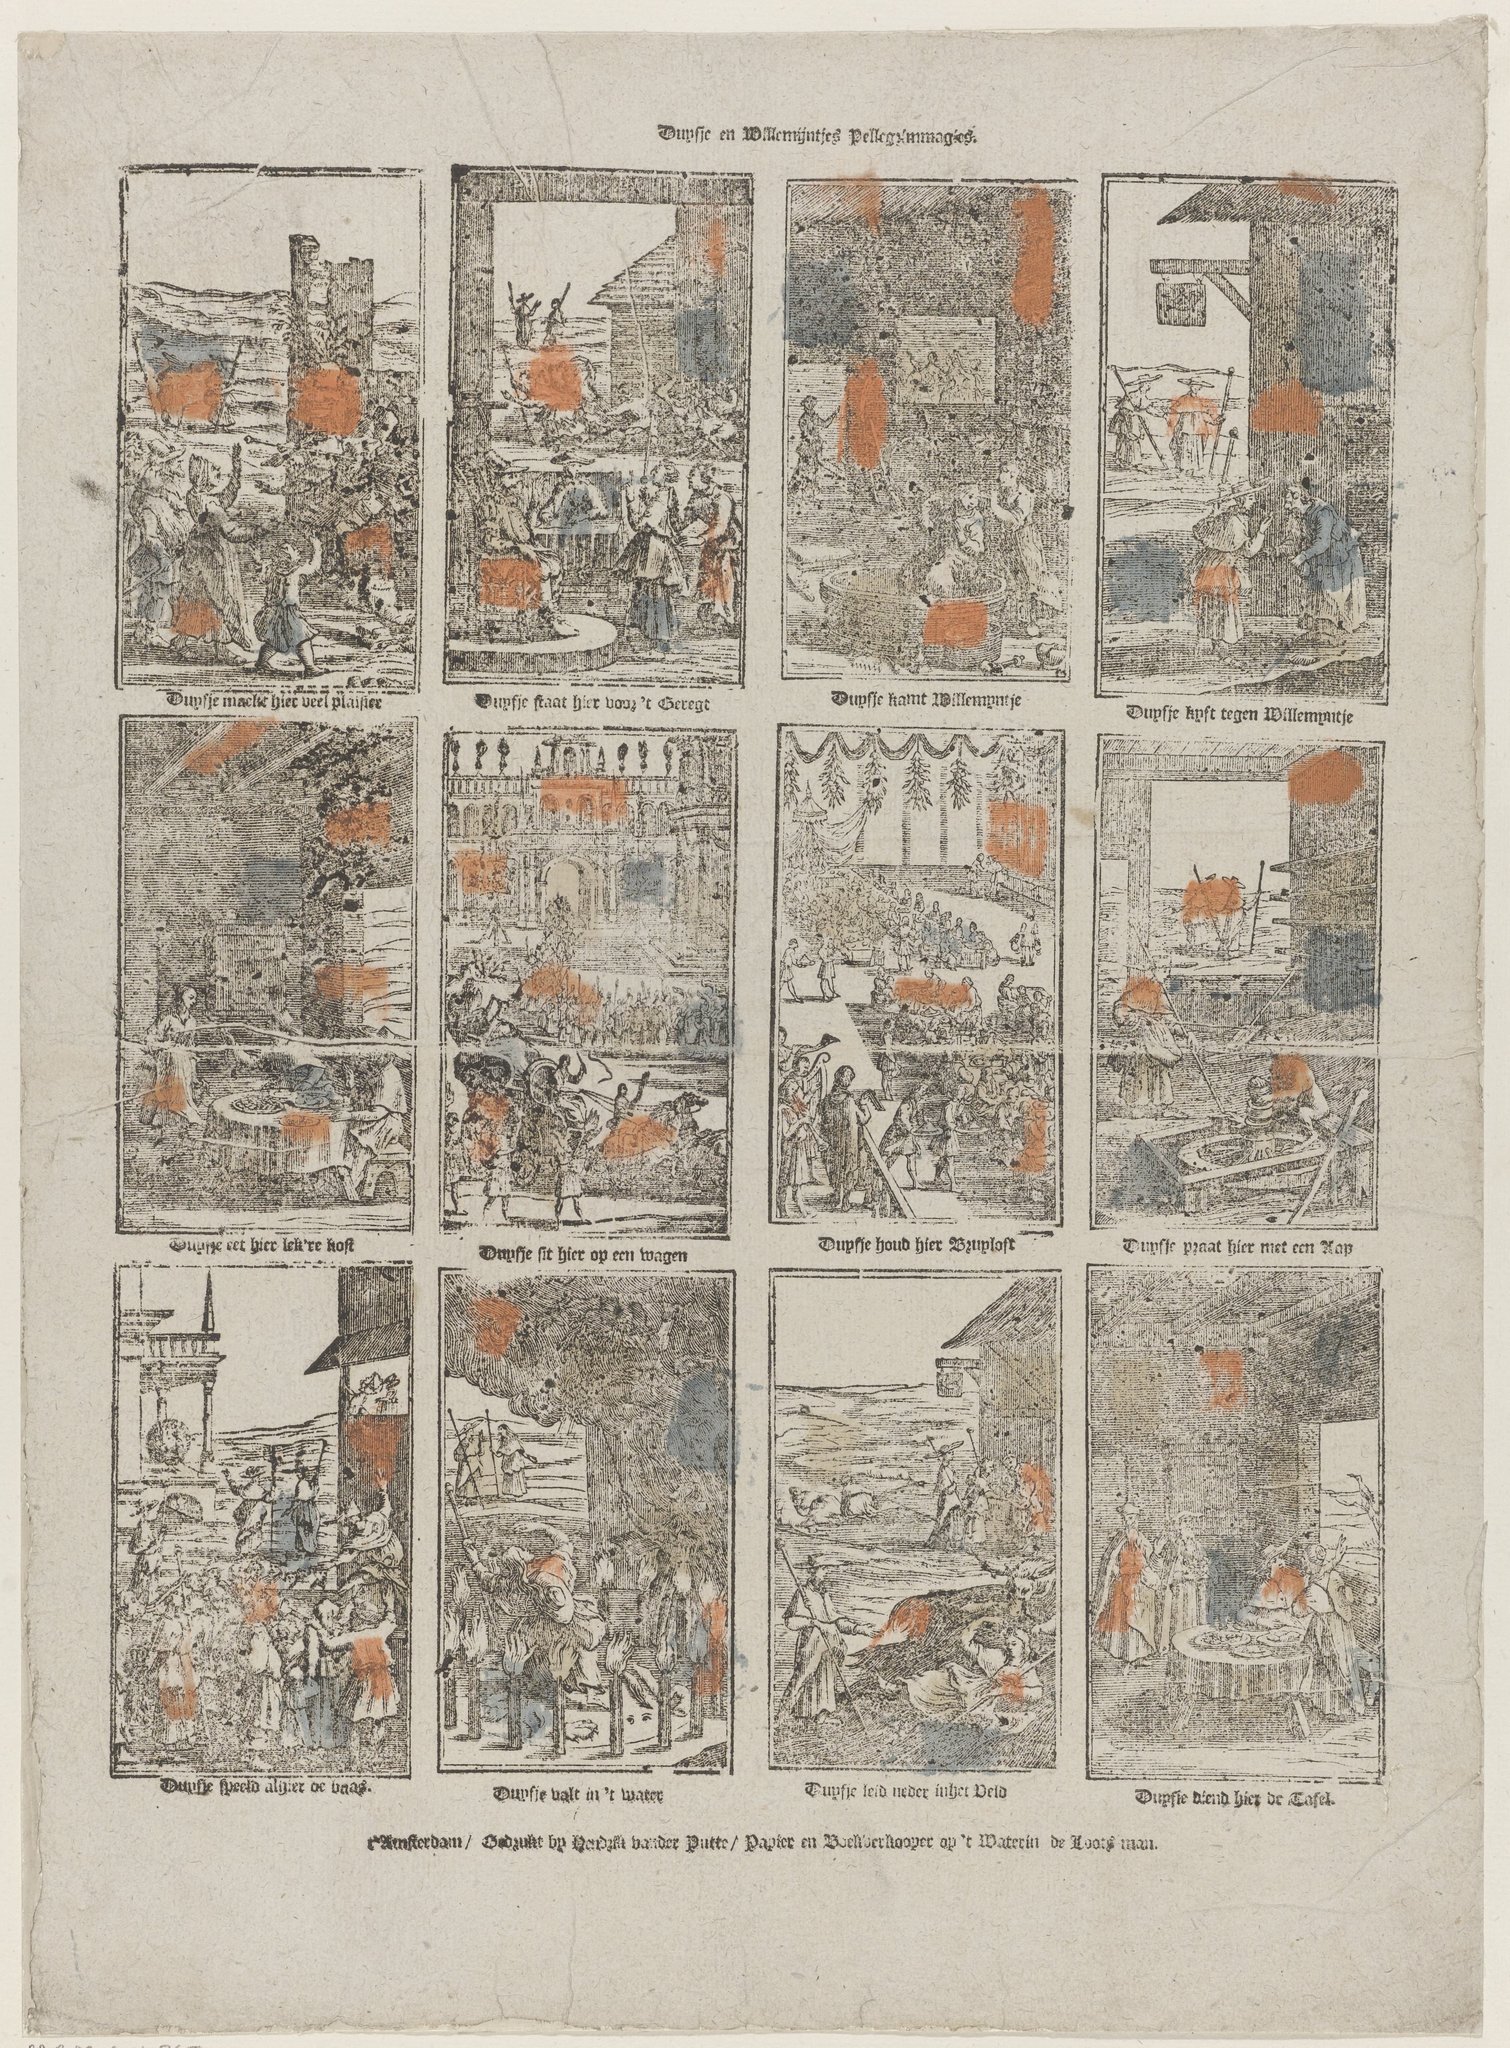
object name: popular print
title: Duyfje en Willemijntjes Pellegrimmagies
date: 1761-1765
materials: paper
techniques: colour, letterpress printing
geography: netherlands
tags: pilgrimage, pilgrim(s) under way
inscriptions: collector's mark: Lugt 2760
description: Blad met 12 voorstellingen van de bedevaart van Duyfken en Willemijn. Onder elke afbeelding een onderschrift.